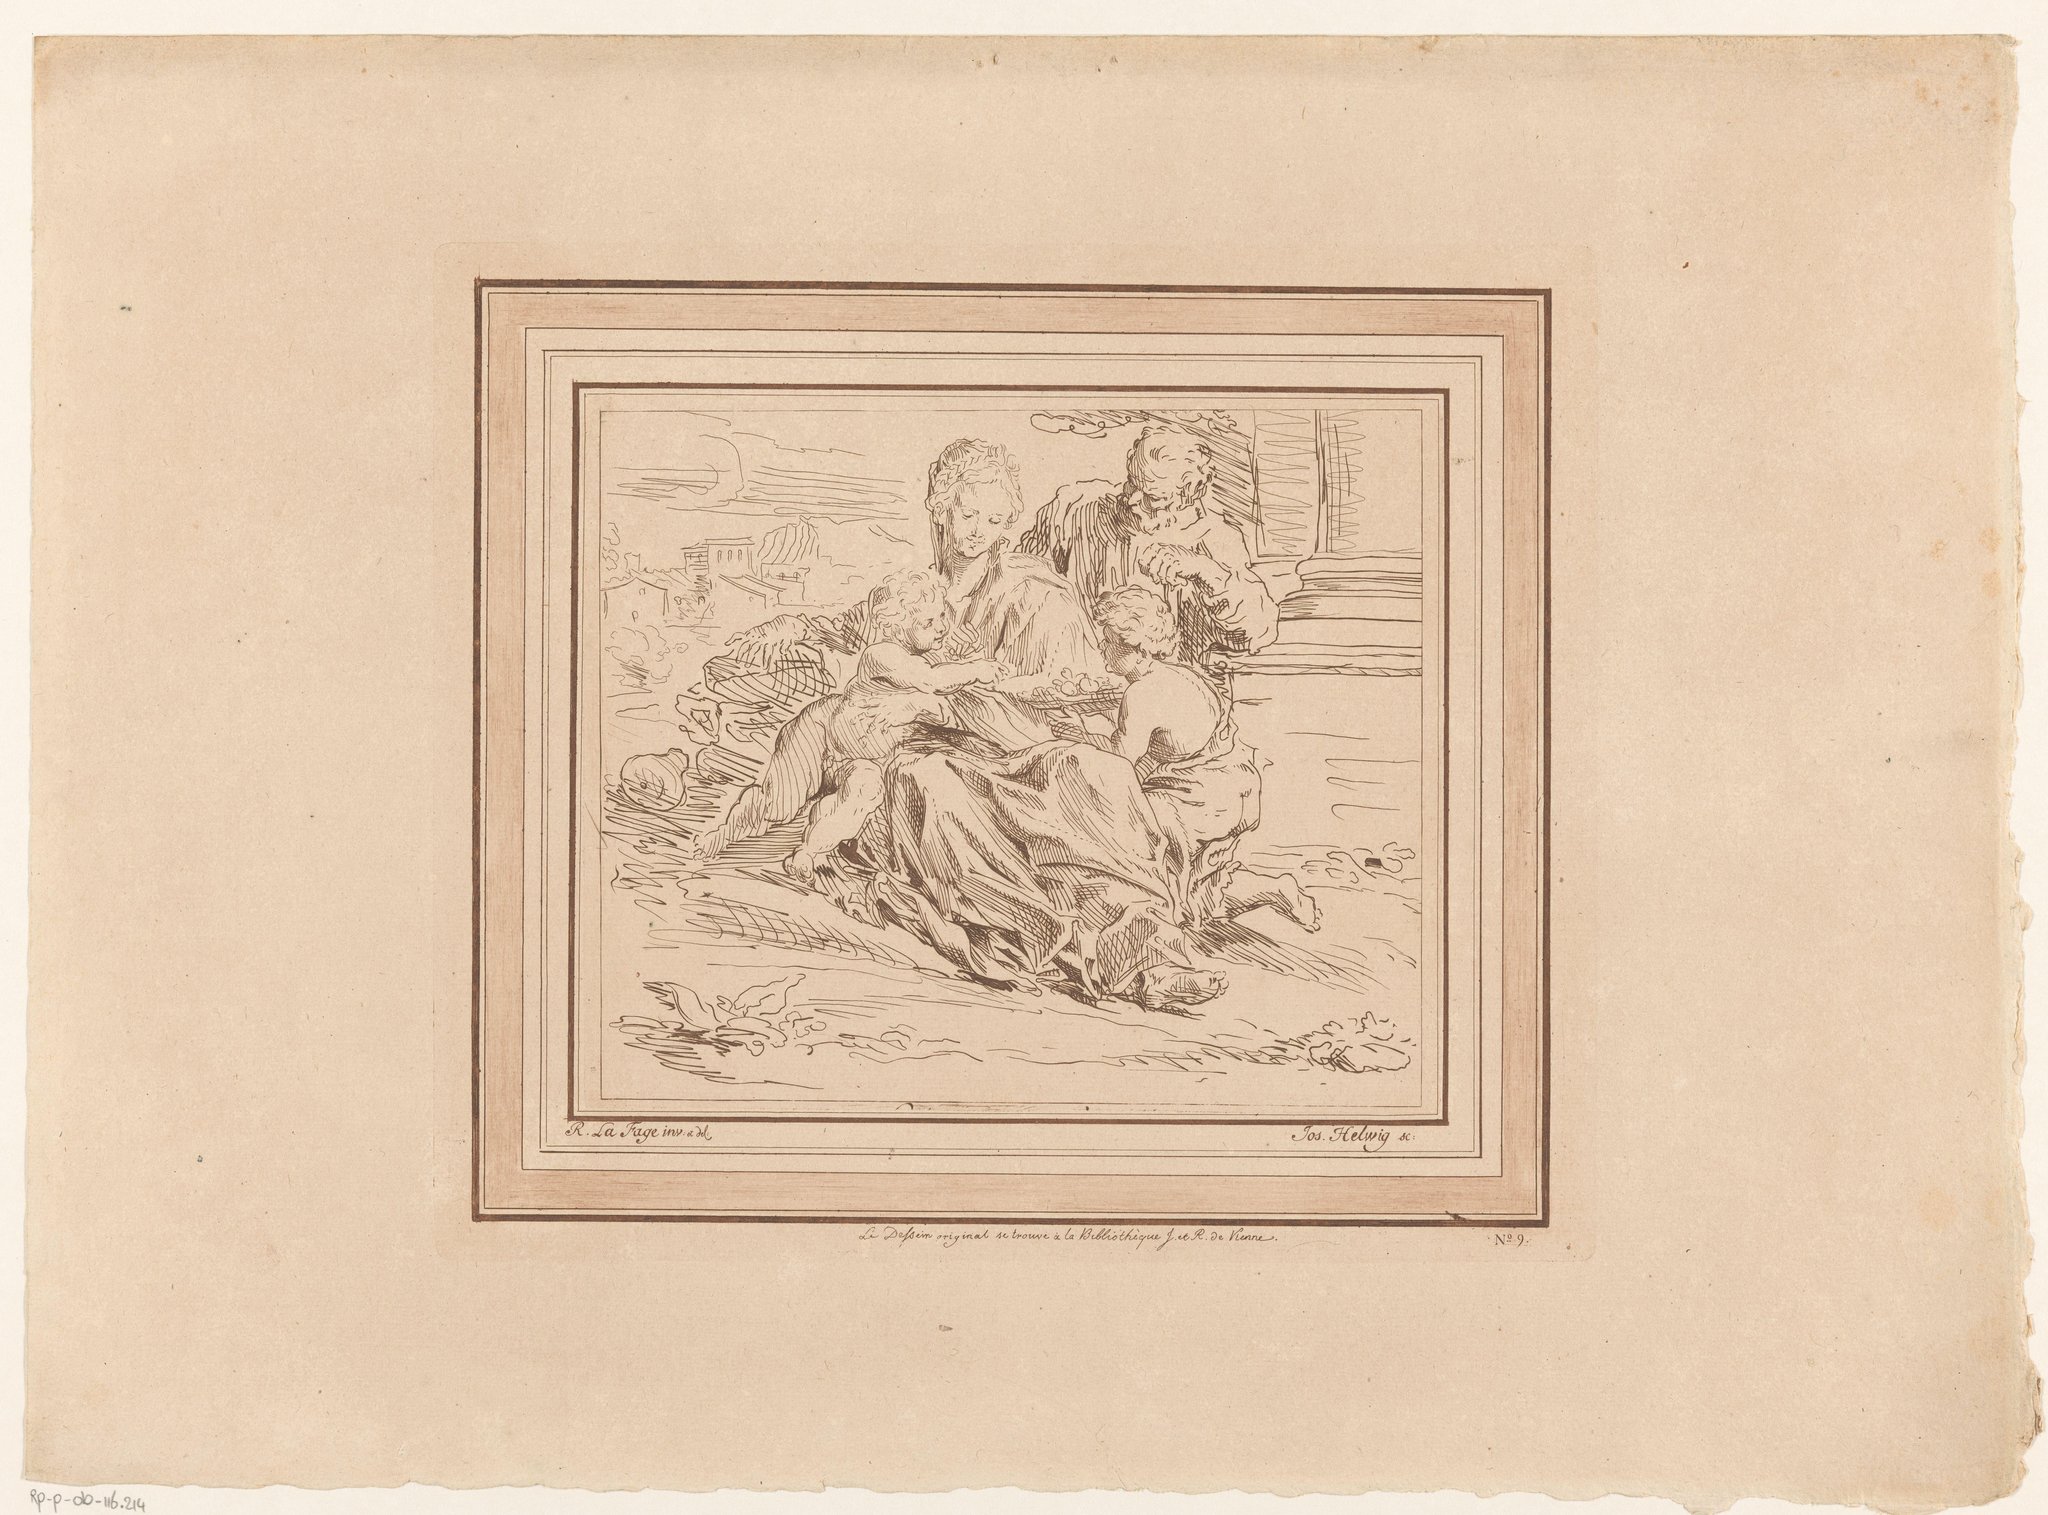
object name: print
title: Heilige Familie met Johannes de Doper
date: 1780-1784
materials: paper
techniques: etching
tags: holy family with john the baptist (as child)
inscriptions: collector's mark: Lugt 2228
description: Één van de prenten naar tekeningen van Raymond de Lafage bewaard in de Hofbibliothek te Wenen.